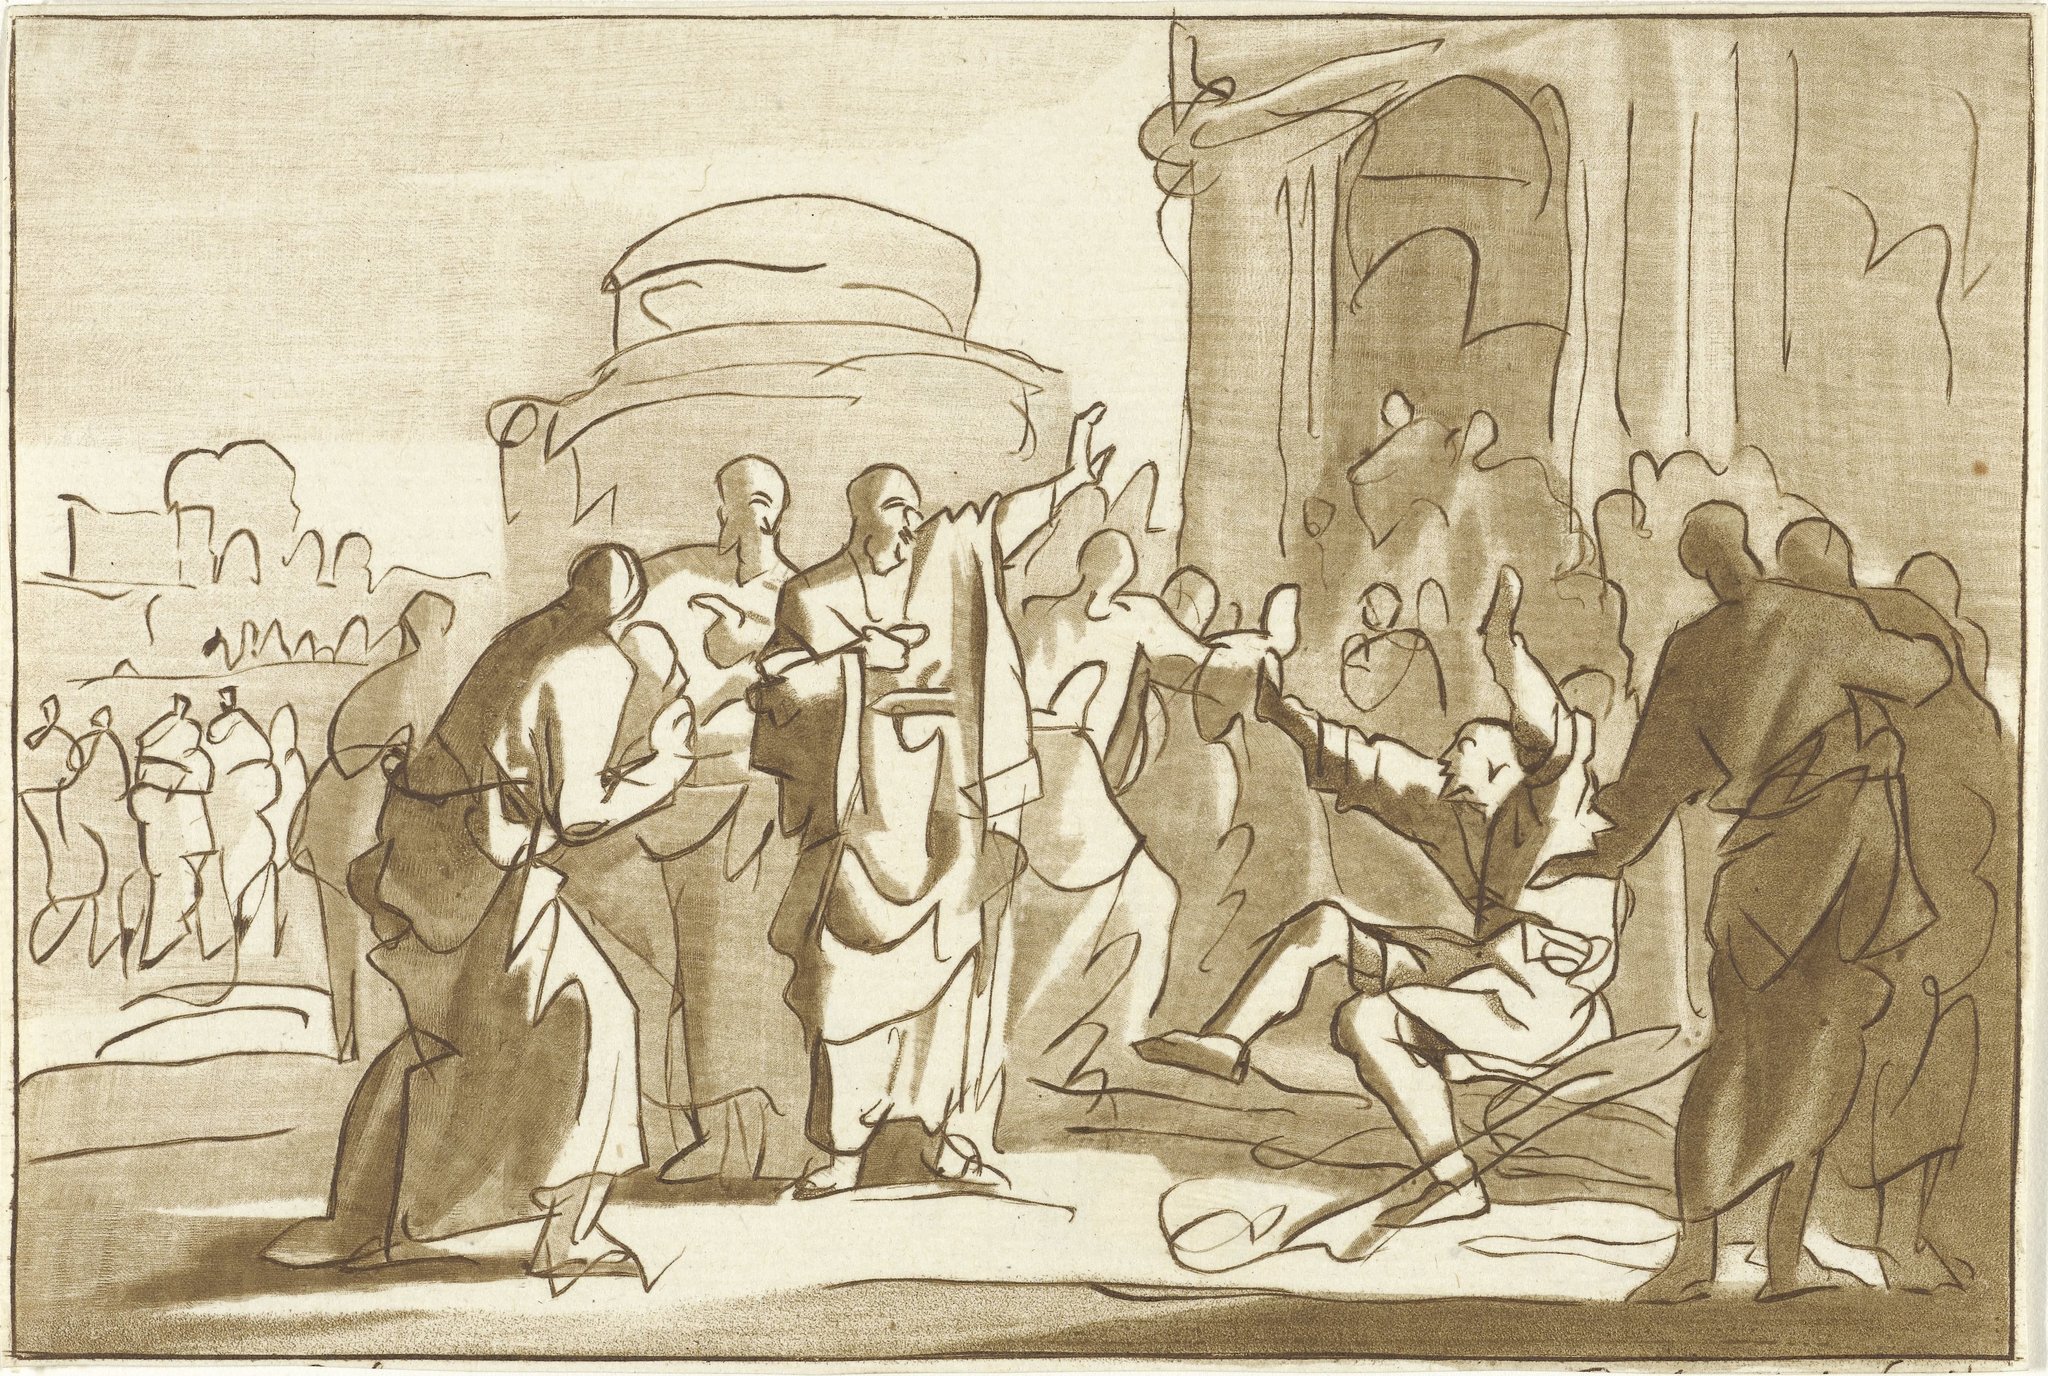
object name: print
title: Peter and John heal a paralyzed man at the temple gate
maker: benjamin martini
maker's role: print maker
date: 1777-1780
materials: paper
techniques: aquatint, etching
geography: amsterdam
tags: healing of a lame beggar at the beautiful gate of the temple by peter and john (acts 3 - 4:31)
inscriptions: collector's mark: Lugt 240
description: De voorstelling is gebaseerd op de tekst uit Handelingen 3:4-31. In de Statenvertaling is de bedelaar beschreven als: “En een zeker man, die kreupel was van zijner moeders lijf, werd gedragen, welken zij dagelijks zetten aan de deur des tempels (…) Maar Petrus zei (…) In den Naam van Jezus Christus den Nazaréner, sta op en wandel. En hem grijpende bij de rechterhand, richtte hij hem op, en terstond werden zijn voeten en enkels vast”. In de Nieuwe Bijbelvertaling wordt er niet gesproken over ‘kreupel’ maar over verlamming: “Men had ook een man die al sinds zijn geboorte verlamd was naar de tempel gebracht (…) Maar Petrus zei (…) in de naam van Jezus Christus van Nazareth, sta op en loop.’ Hij pakte hem bij zijn rechterhand om hem overeind te helpen. Onmiddellijk kwam er kracht in zijn voeten en enkels.”